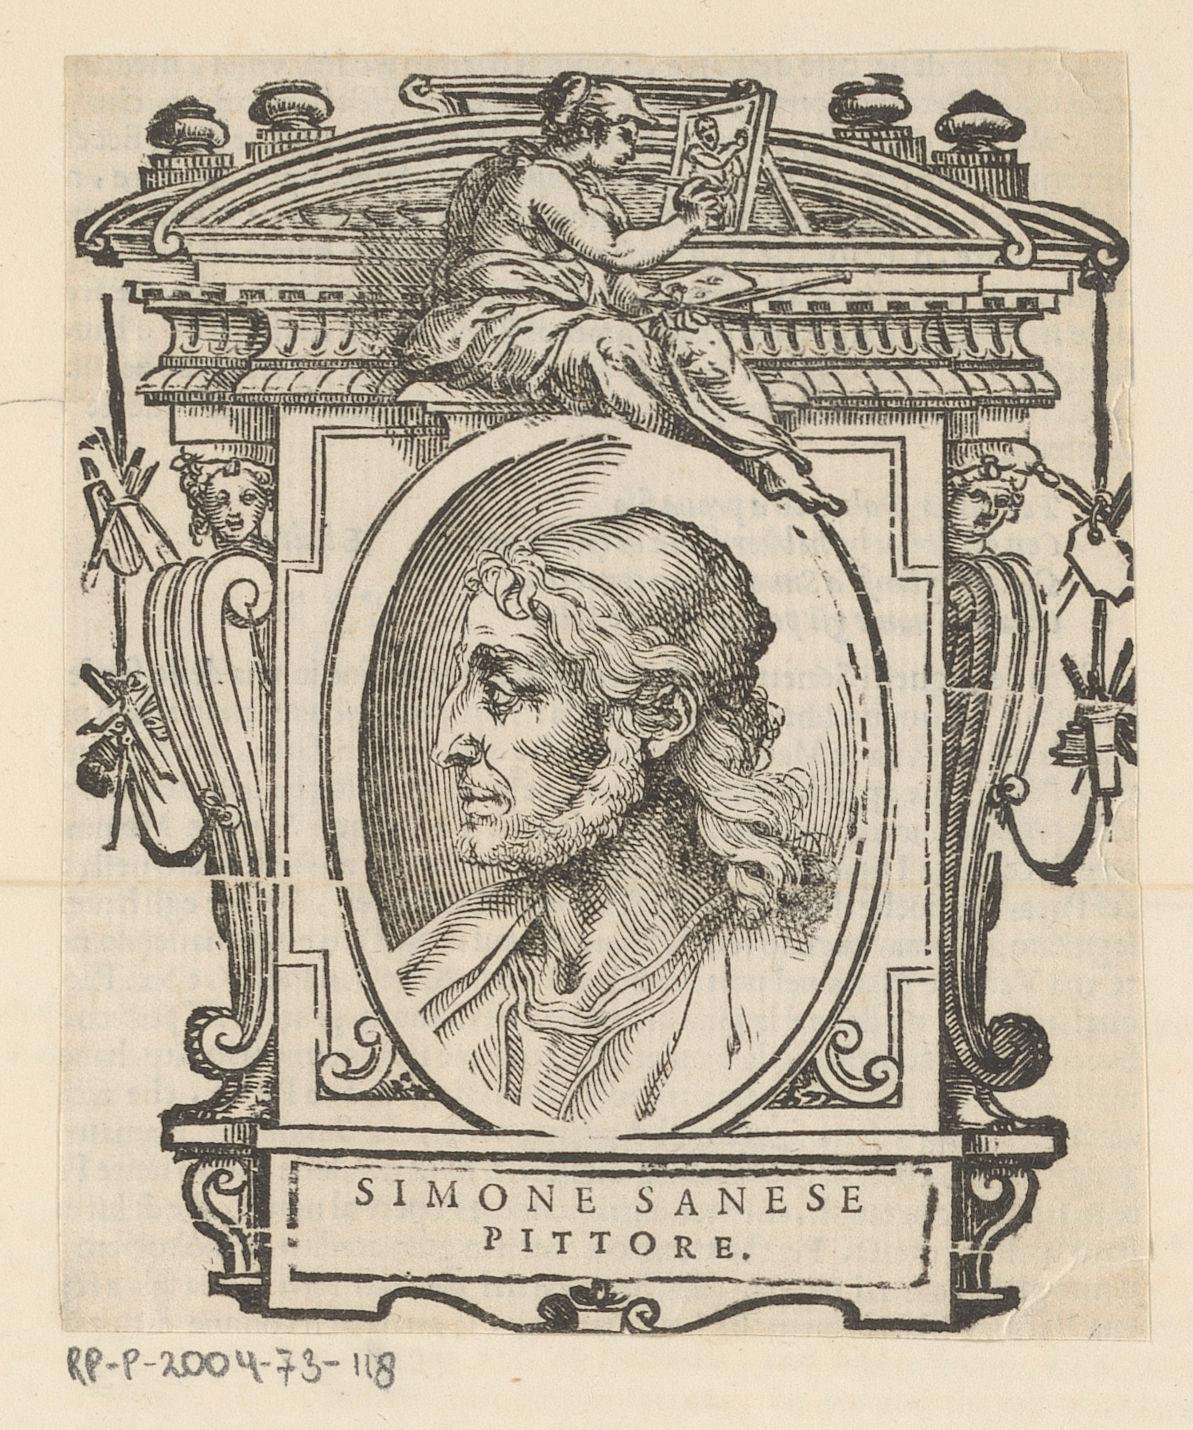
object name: album leaf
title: Portret van Simone Martini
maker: Anonymous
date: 1568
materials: paper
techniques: letterpress printing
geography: florence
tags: painter, simone martini, historical persons, portrait, self-portrait of painter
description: Eerdere staat van prent gebruikt in: Vasari, Giorgio. Le Vite de' più eccellenti pittori, scultori, e architettori da Cimabue insino a' tempi nostri. 4 dln. Florence: Giunti, 1568, dl. 2, p. 169. De samensteller heeft deze prent in het album geplakt als illustratie bij: Pilkington, Matthew en Johann Heinrich Füssli. A dictionary of painters, from the revival of the art to the present period. 4 dln. Londen: John Crowder, 1805, dl. 2, p. 327.